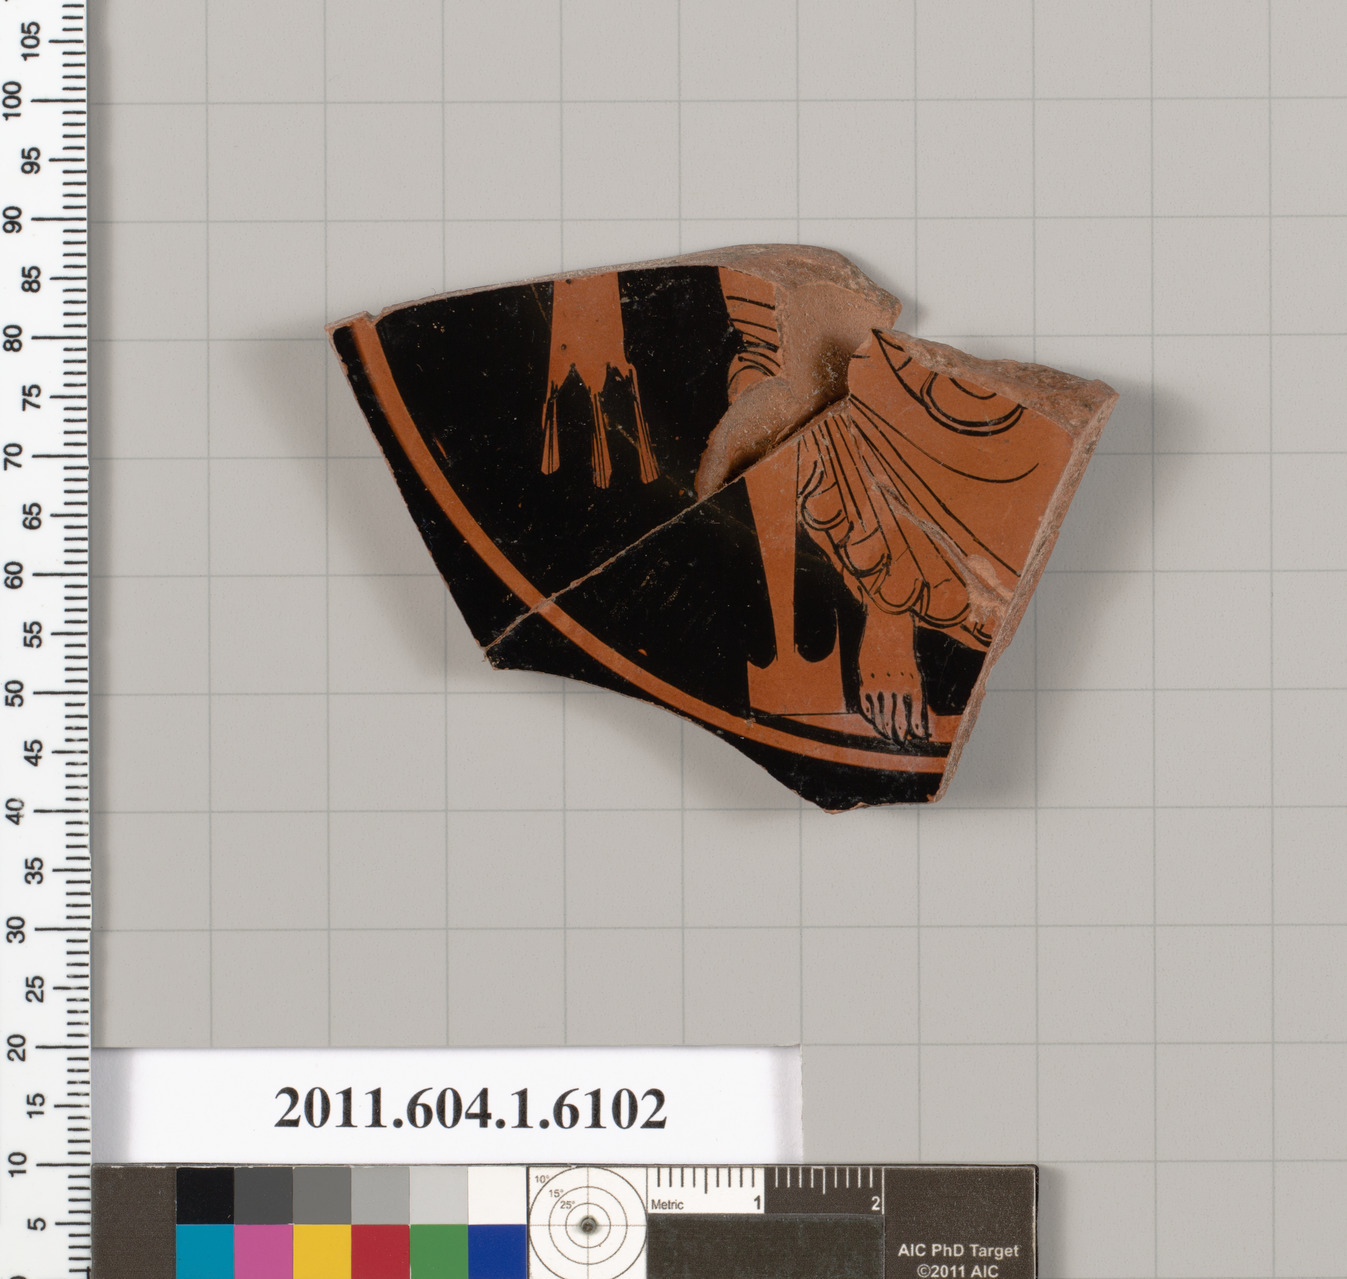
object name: kylix fragment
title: Terracotta fragment of a kylix (drinking cup)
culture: greek, attic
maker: apollodoros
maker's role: artist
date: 500-490 BCE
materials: terracotta